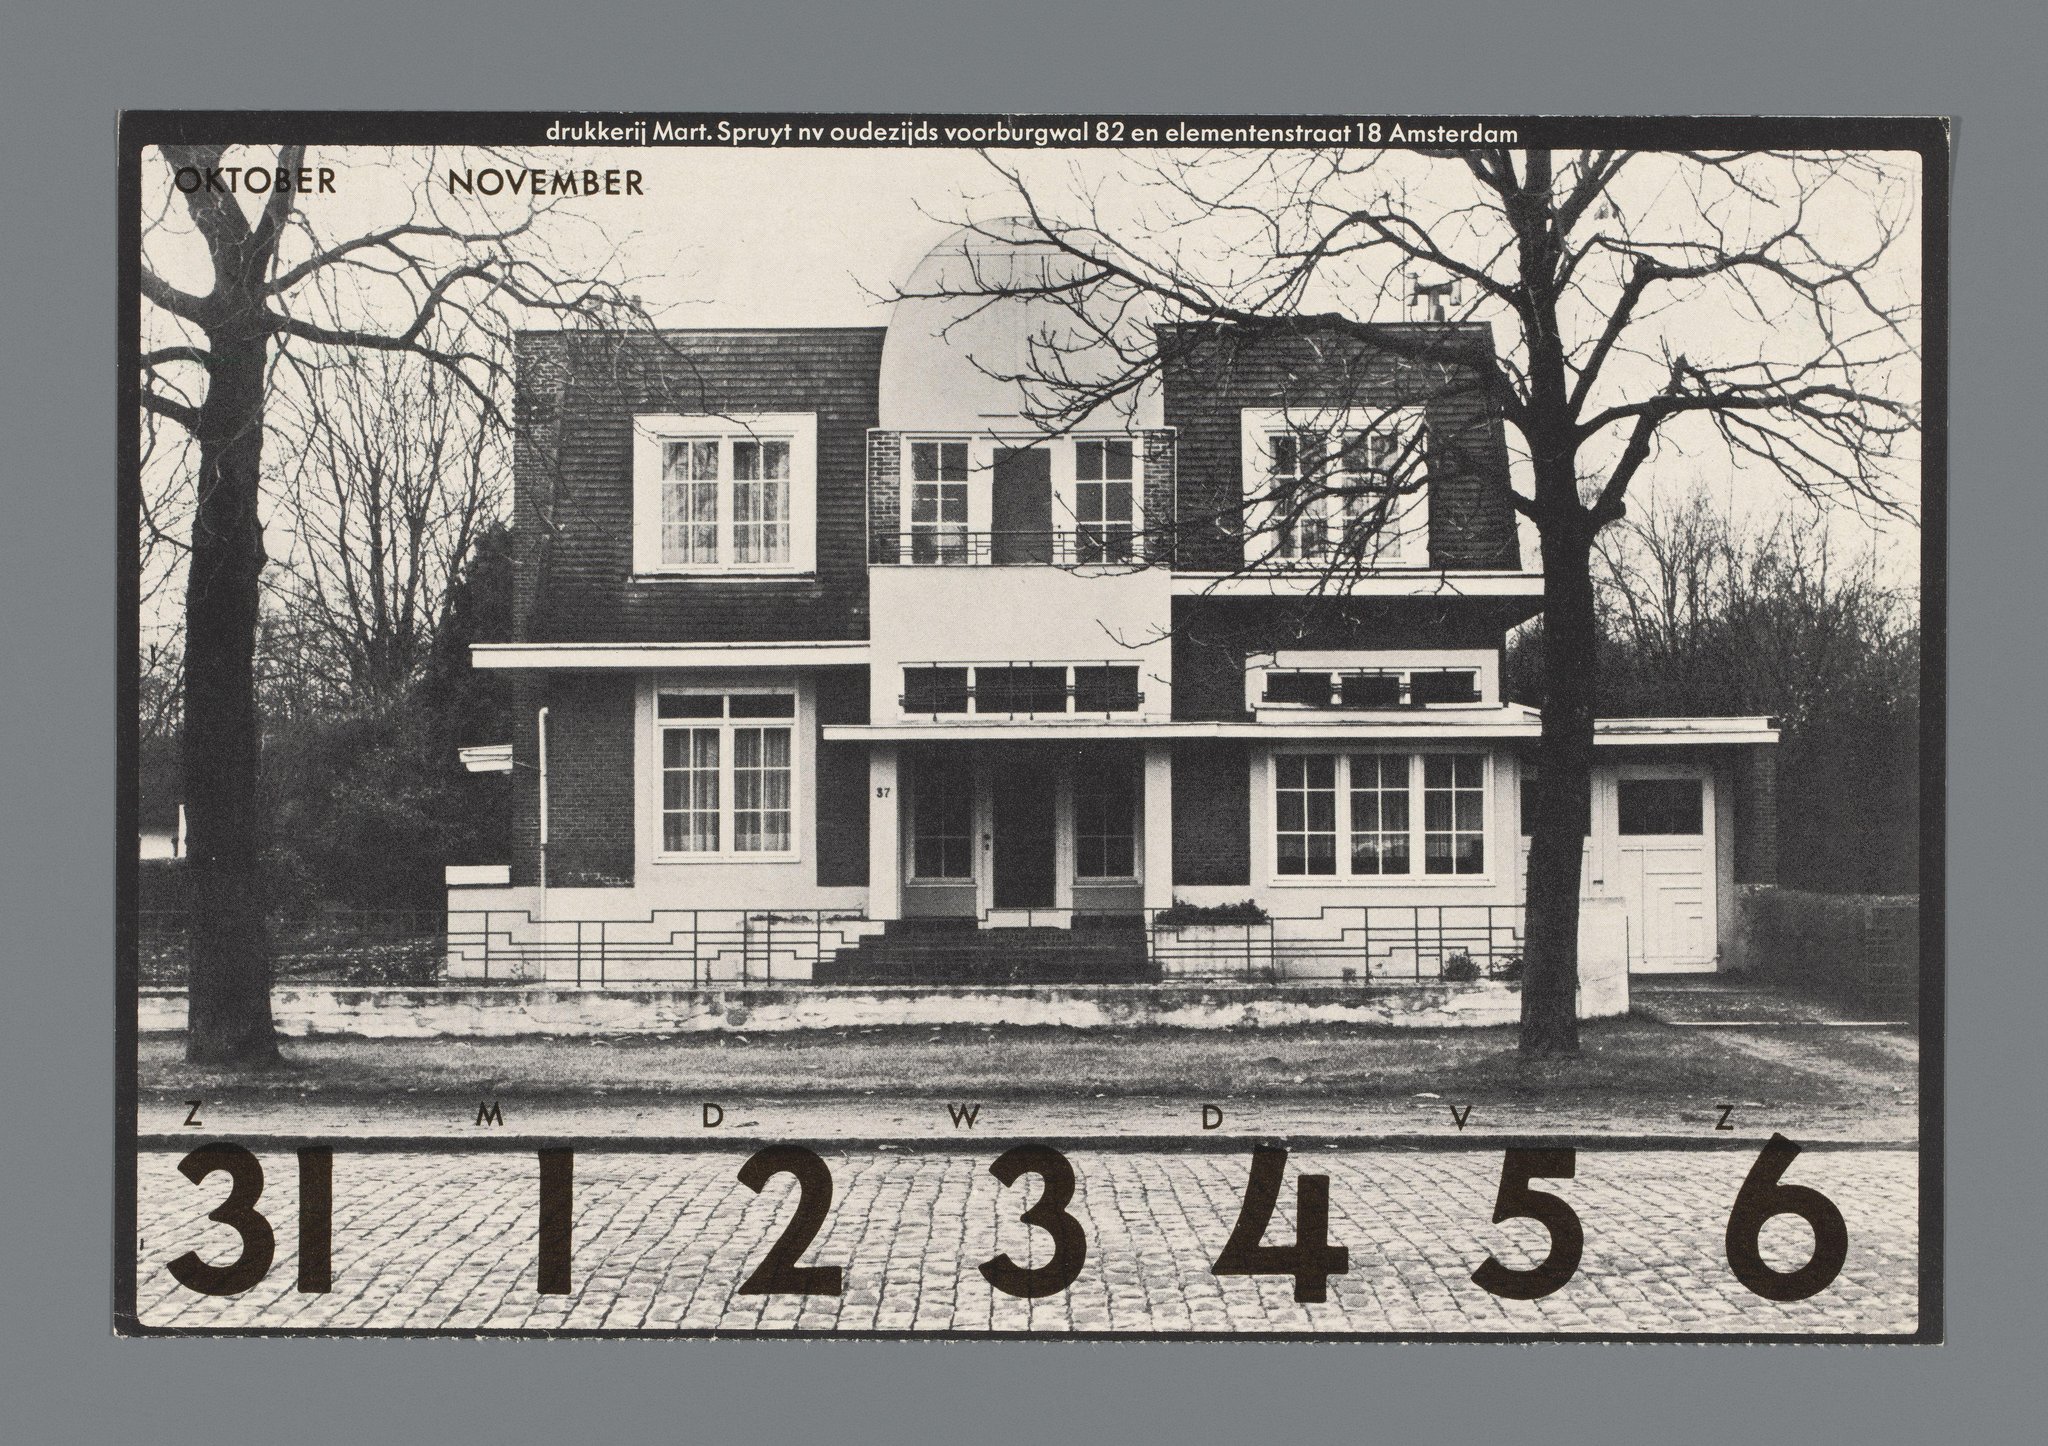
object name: photograph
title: België. Huizen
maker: Anonymous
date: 1900-1950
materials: paper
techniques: offset printed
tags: belgium